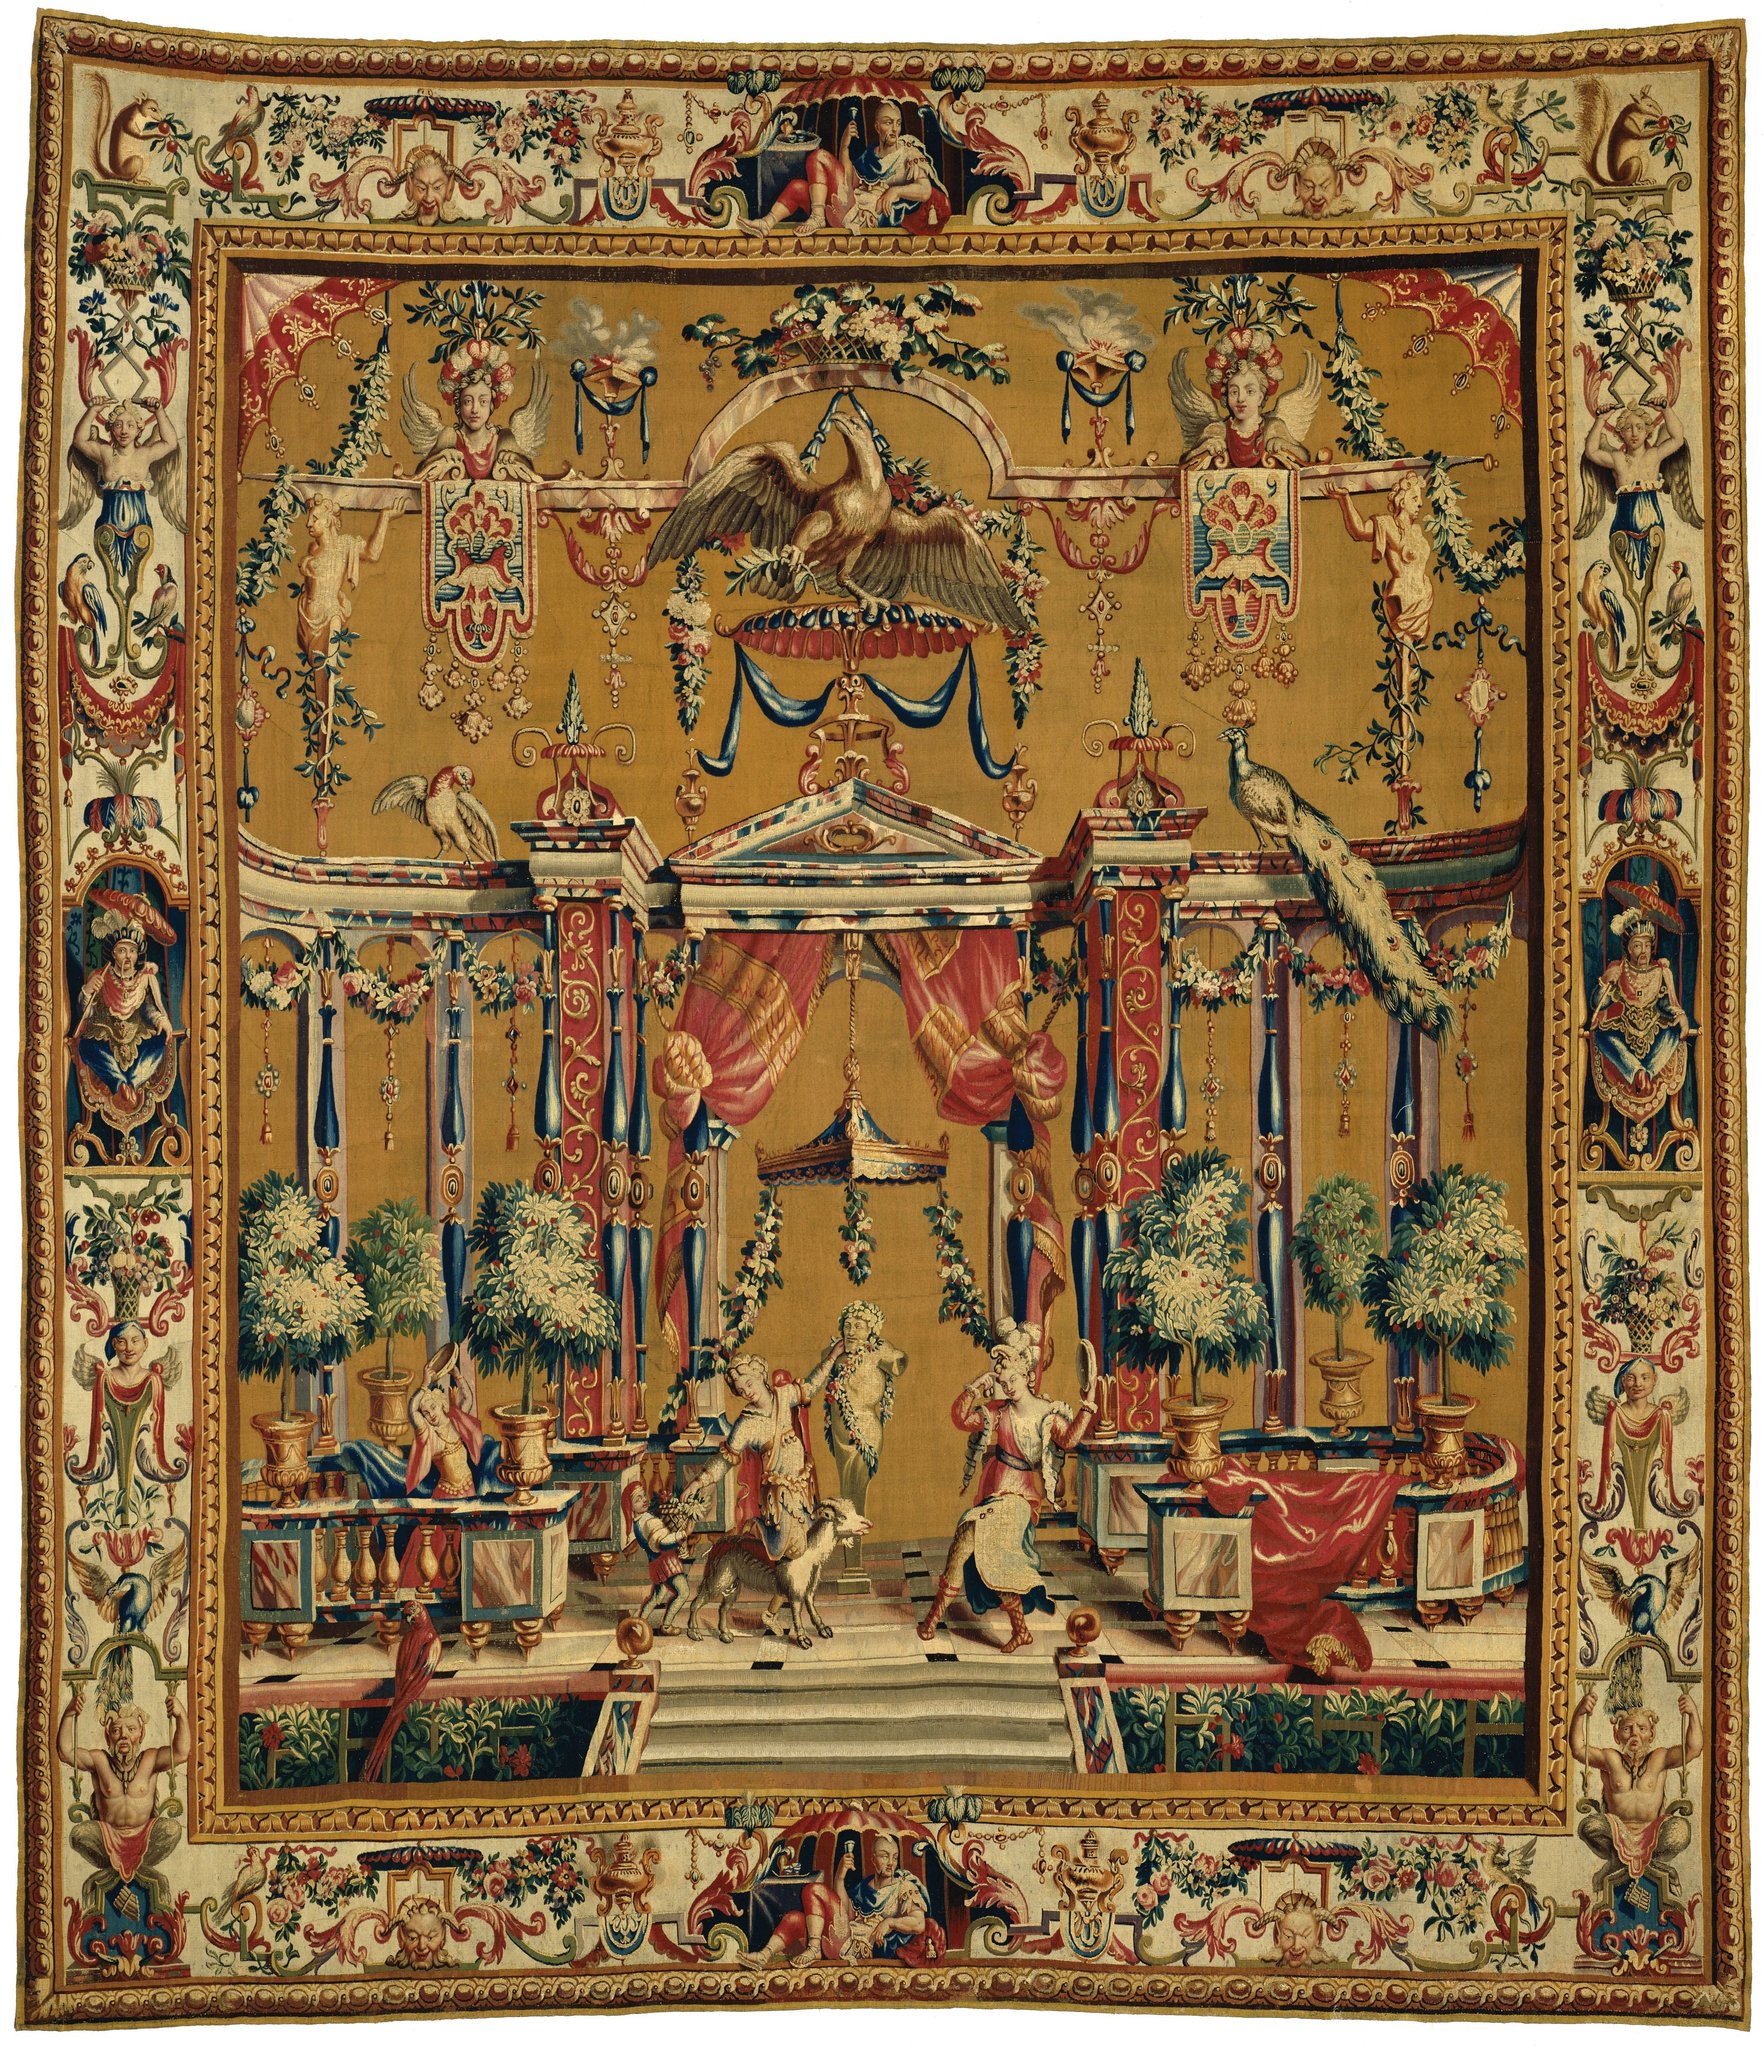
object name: tapestry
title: Het offer aan Pan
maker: jean baptiste monnoyer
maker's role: designer, painter, print maker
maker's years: 1636-1699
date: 1688-1732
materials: silk, wool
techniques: tapestry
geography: beauvais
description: Wandtapijt met het offer aan Pan uit een serie tapijten met grotesken.